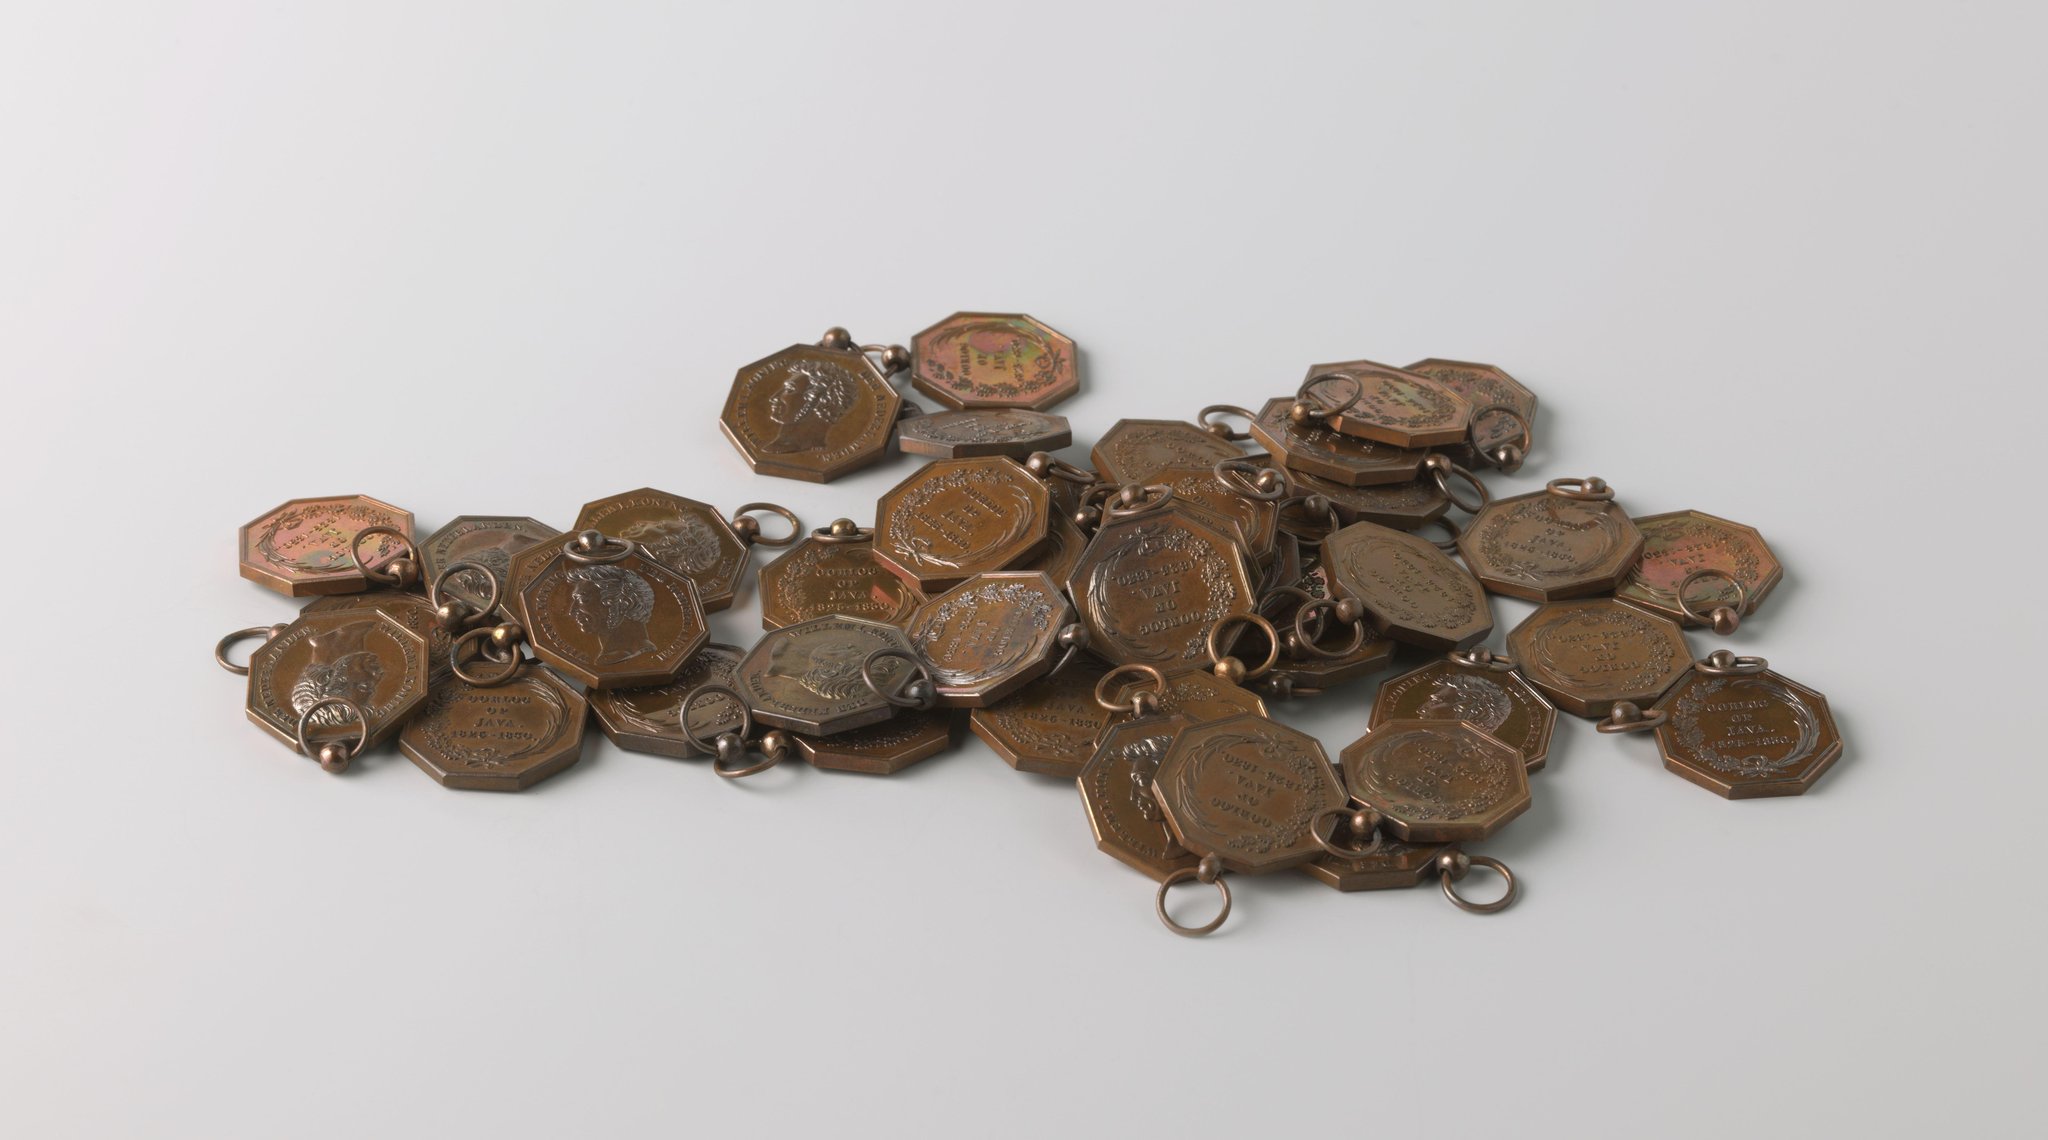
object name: insignia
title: Oorlog op Java, groot draagteken uitgereikt aan de deelnemers, ter ere van Willem I Frederik, koning der Nederlanden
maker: david van der kellen (1804-1879)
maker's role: die cutter, draughtsman, print maker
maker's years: 1804-1879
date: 1830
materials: bronze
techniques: striking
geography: utrecht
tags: the hague, berlin, william i of the netherlands, java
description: Achthoekig draagteken aan draagoog en draagring. Voorzijde: borststuk man binnen omschrift. Keerzijde: opschrift binnen tot krans samengebonden palm- en eiketak; twee aan draaglint.